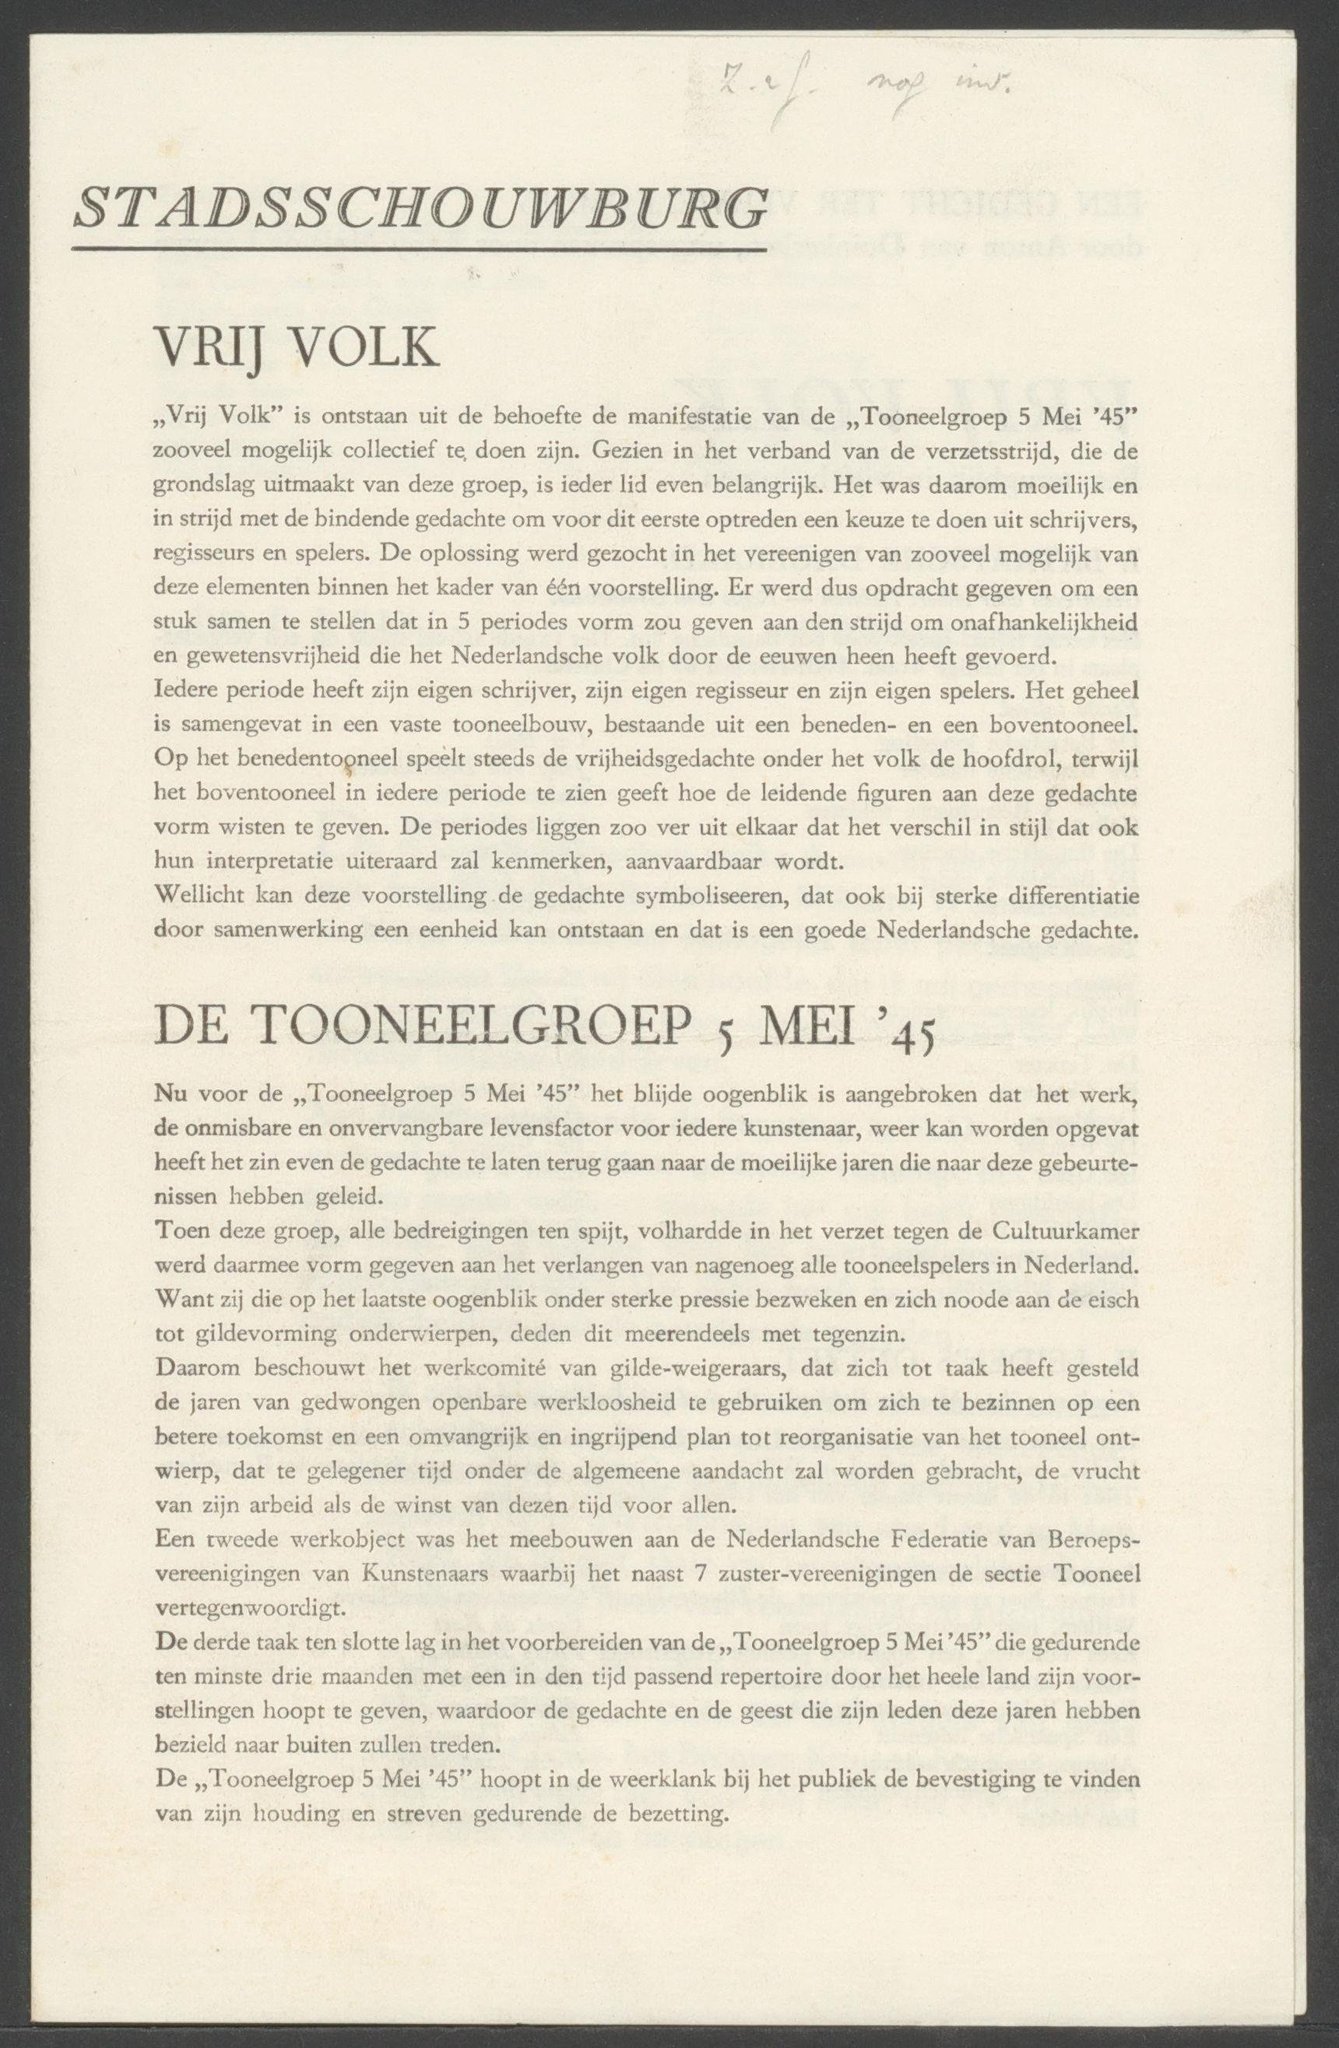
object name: text sheet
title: Programma van het toneelstuk 'Vrij Volk'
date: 1945-1946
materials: paper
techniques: printing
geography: netherlands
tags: jonkheer pieter jacob six, theatre, theatrical performance, medals and other marks of military honour